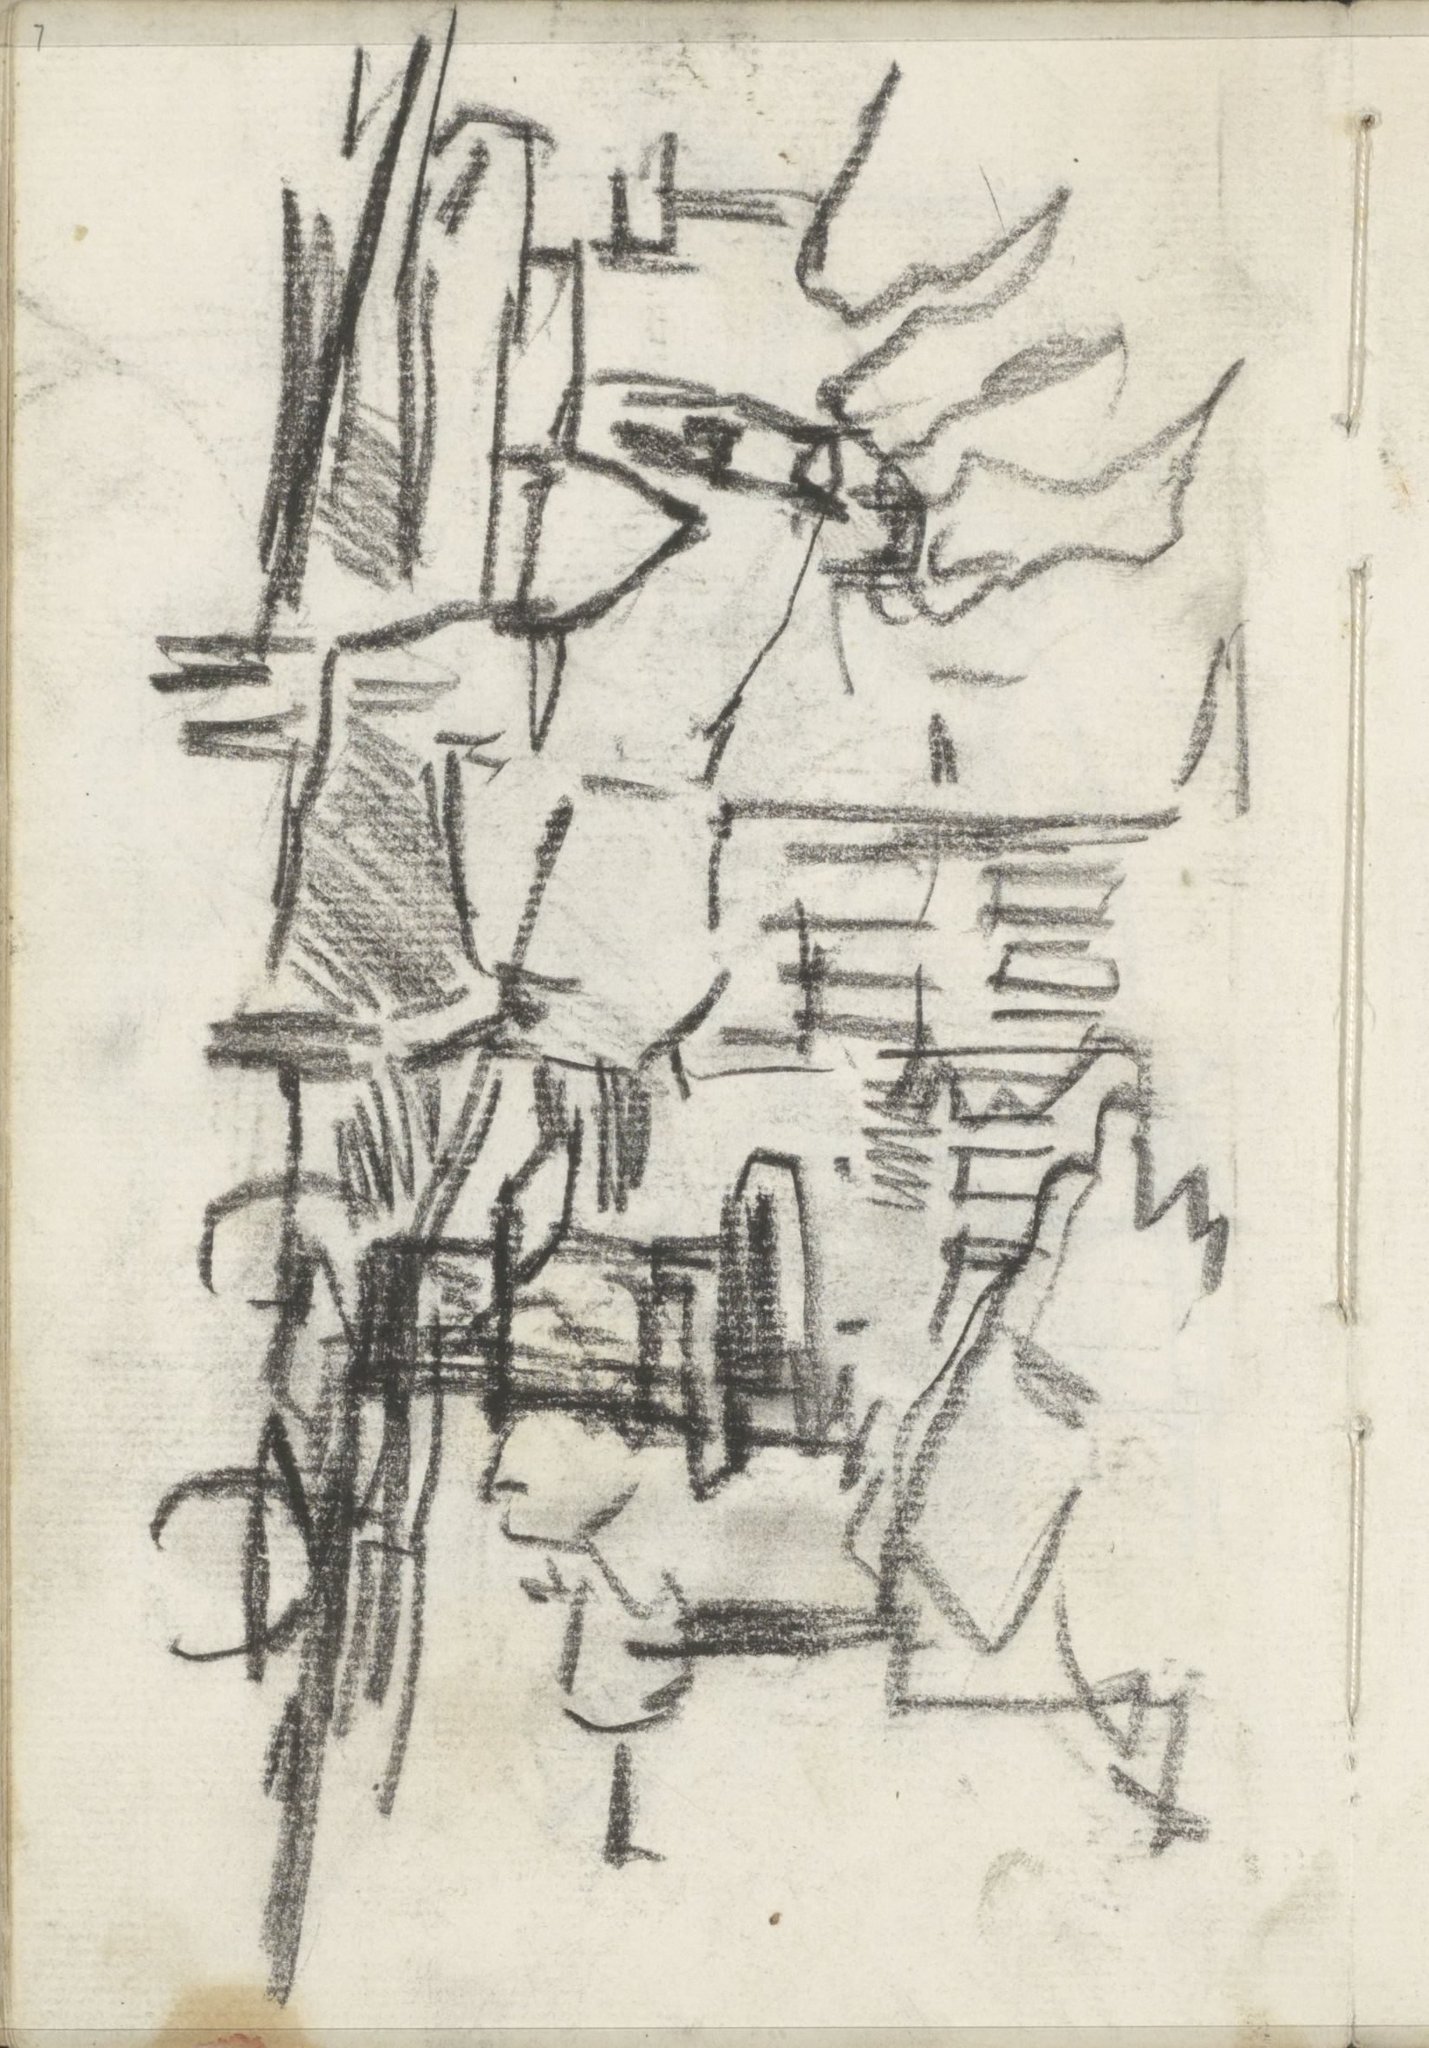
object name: sketchbook leaf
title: Gezicht in Amsterdam met een paard-en-wagen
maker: george hendrik breitner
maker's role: draughtsman, painter, print maker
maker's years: 1857-1923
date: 1895-1898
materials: chalk, paper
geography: amsterdam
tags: city-view, and landscape with man-made constructions, horse, civic architecture; edifices; dwellings, (farm) wagon, freight wagon, cart, amsterdam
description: Pagina 7 uit een schetsboek met 20 bladen.